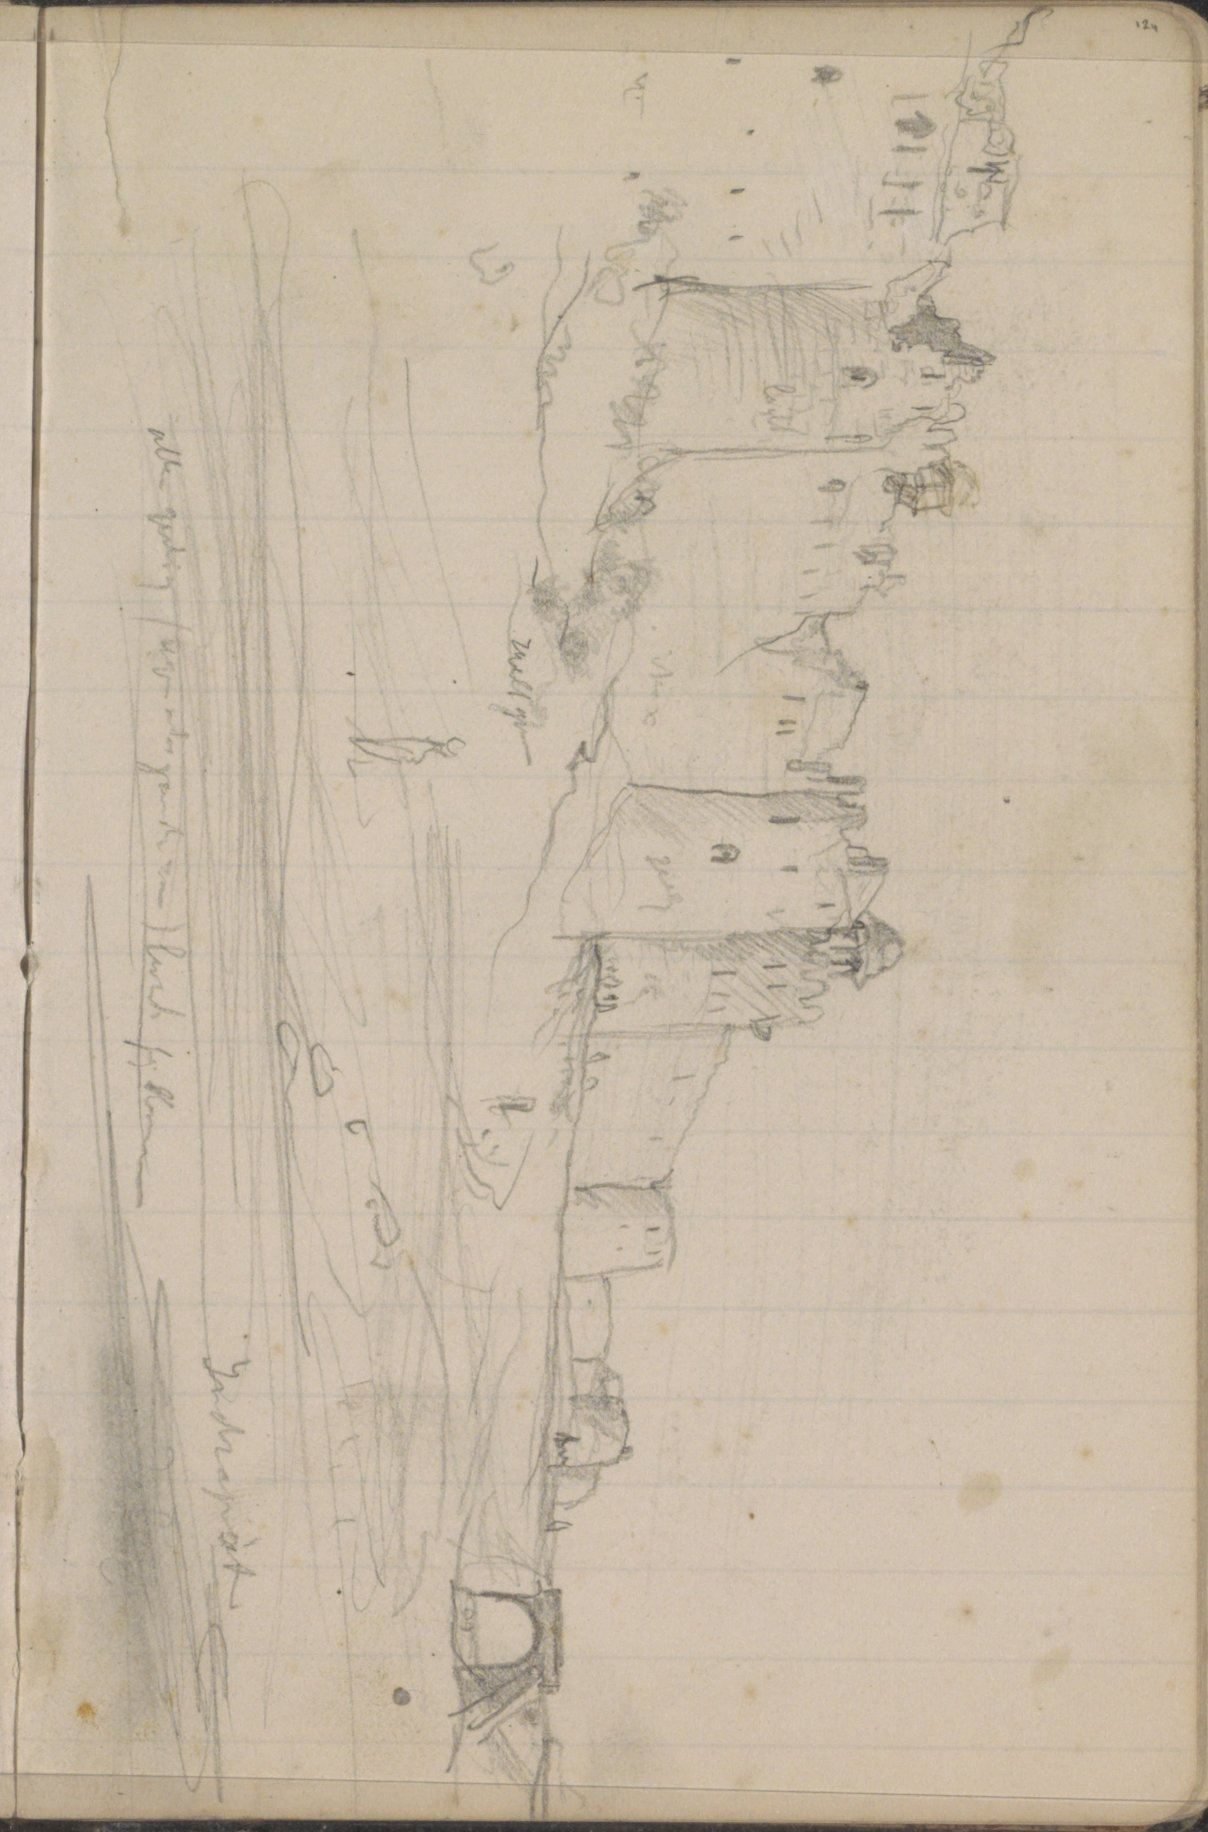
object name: sketchbook leaf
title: Muur en torens van het fort Indrapat in Delhi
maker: marius bauer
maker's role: draughtsman, print maker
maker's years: 1867-1932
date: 1897-1898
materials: pencil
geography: delhi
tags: towers ~ fortified city, walls ~ fortified city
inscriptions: annotation: ‘Indrapat’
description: De schets is een voorstudie voor Bauers schilderij 'Stadsmuur in India'.